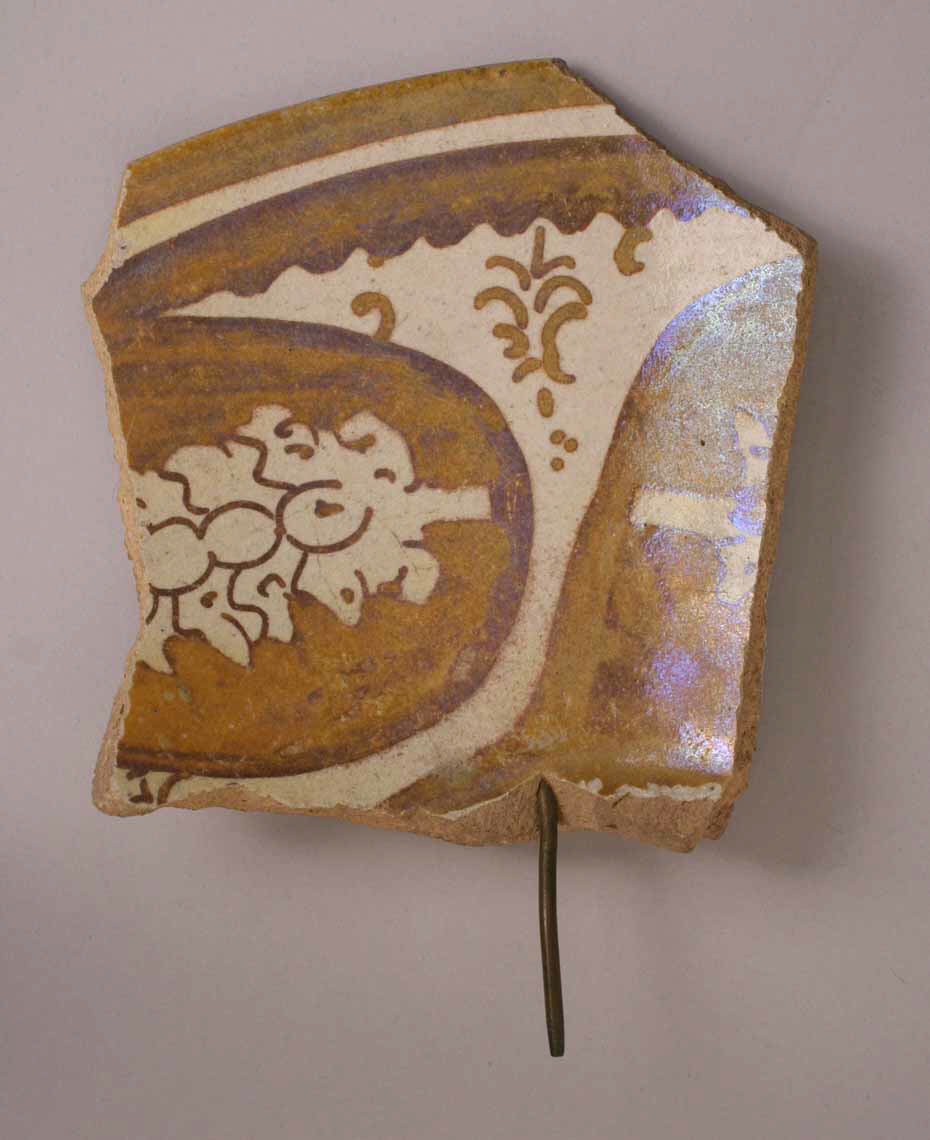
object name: fragment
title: Ceramic Fragment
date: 1001-1200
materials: glaze, stonepaste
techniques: luster painting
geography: egypt